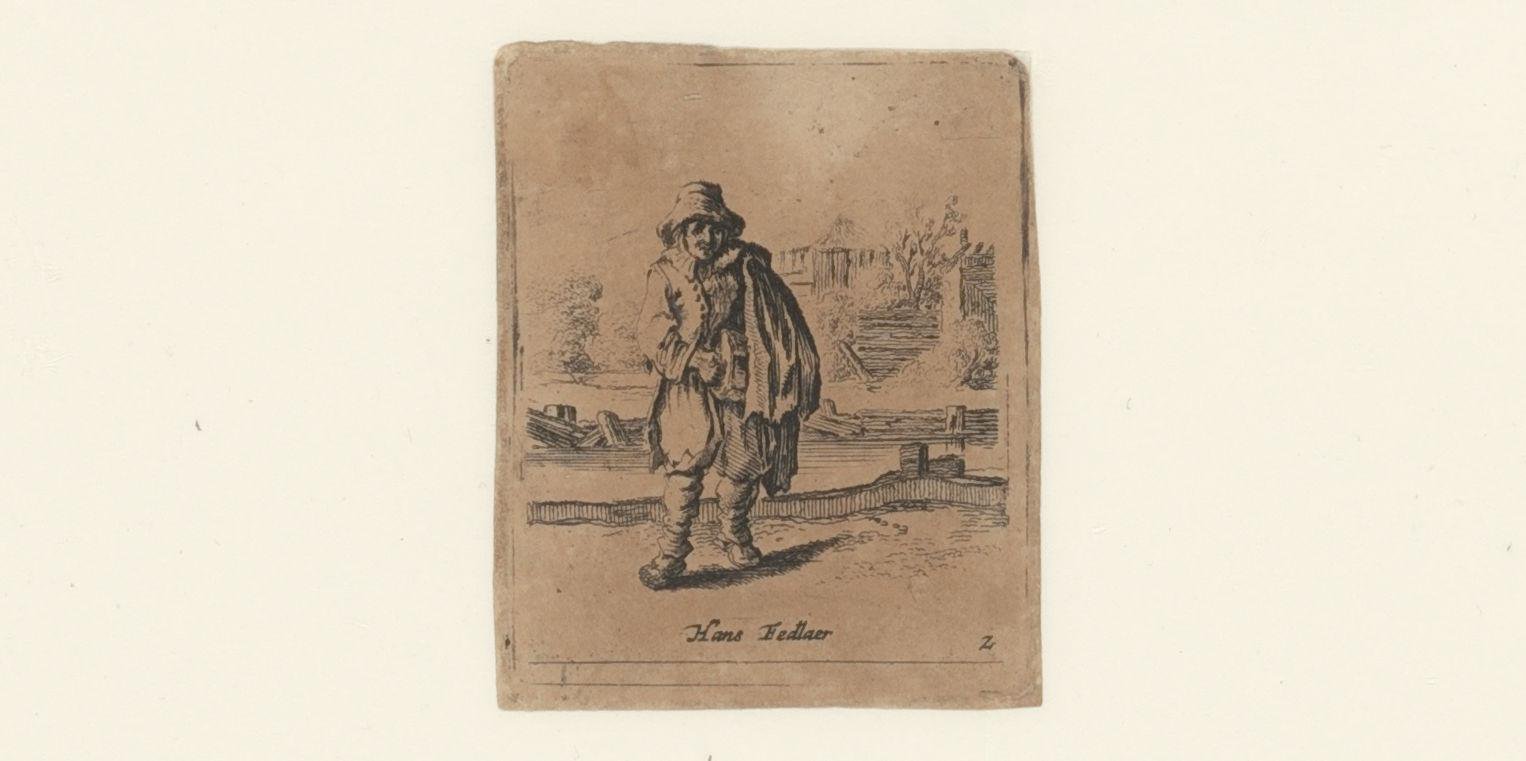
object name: print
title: Hans Fedlaer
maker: gillis van scheyndel (i)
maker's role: draughtsman, print maker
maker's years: 1595-1660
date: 1638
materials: paper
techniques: etching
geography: netherlands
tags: barrel-organ player - cc - out of doors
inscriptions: collector's mark: Lugt 1641, collector's mark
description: Jonge man met hoed en cape bespeelt een draaiorgeltje. De prent maakt deel uit van een serie van 32 prenten met genretaferelen. Rechtsonder genummerd: 2. Onderwerpsrubrieken binnen de Atlas Zeden en Gewoonten: Mannelijk beroep en bedrijf: Marskramers, straatventers, straatslijpers, bedelaars, straatvertooningen enz.